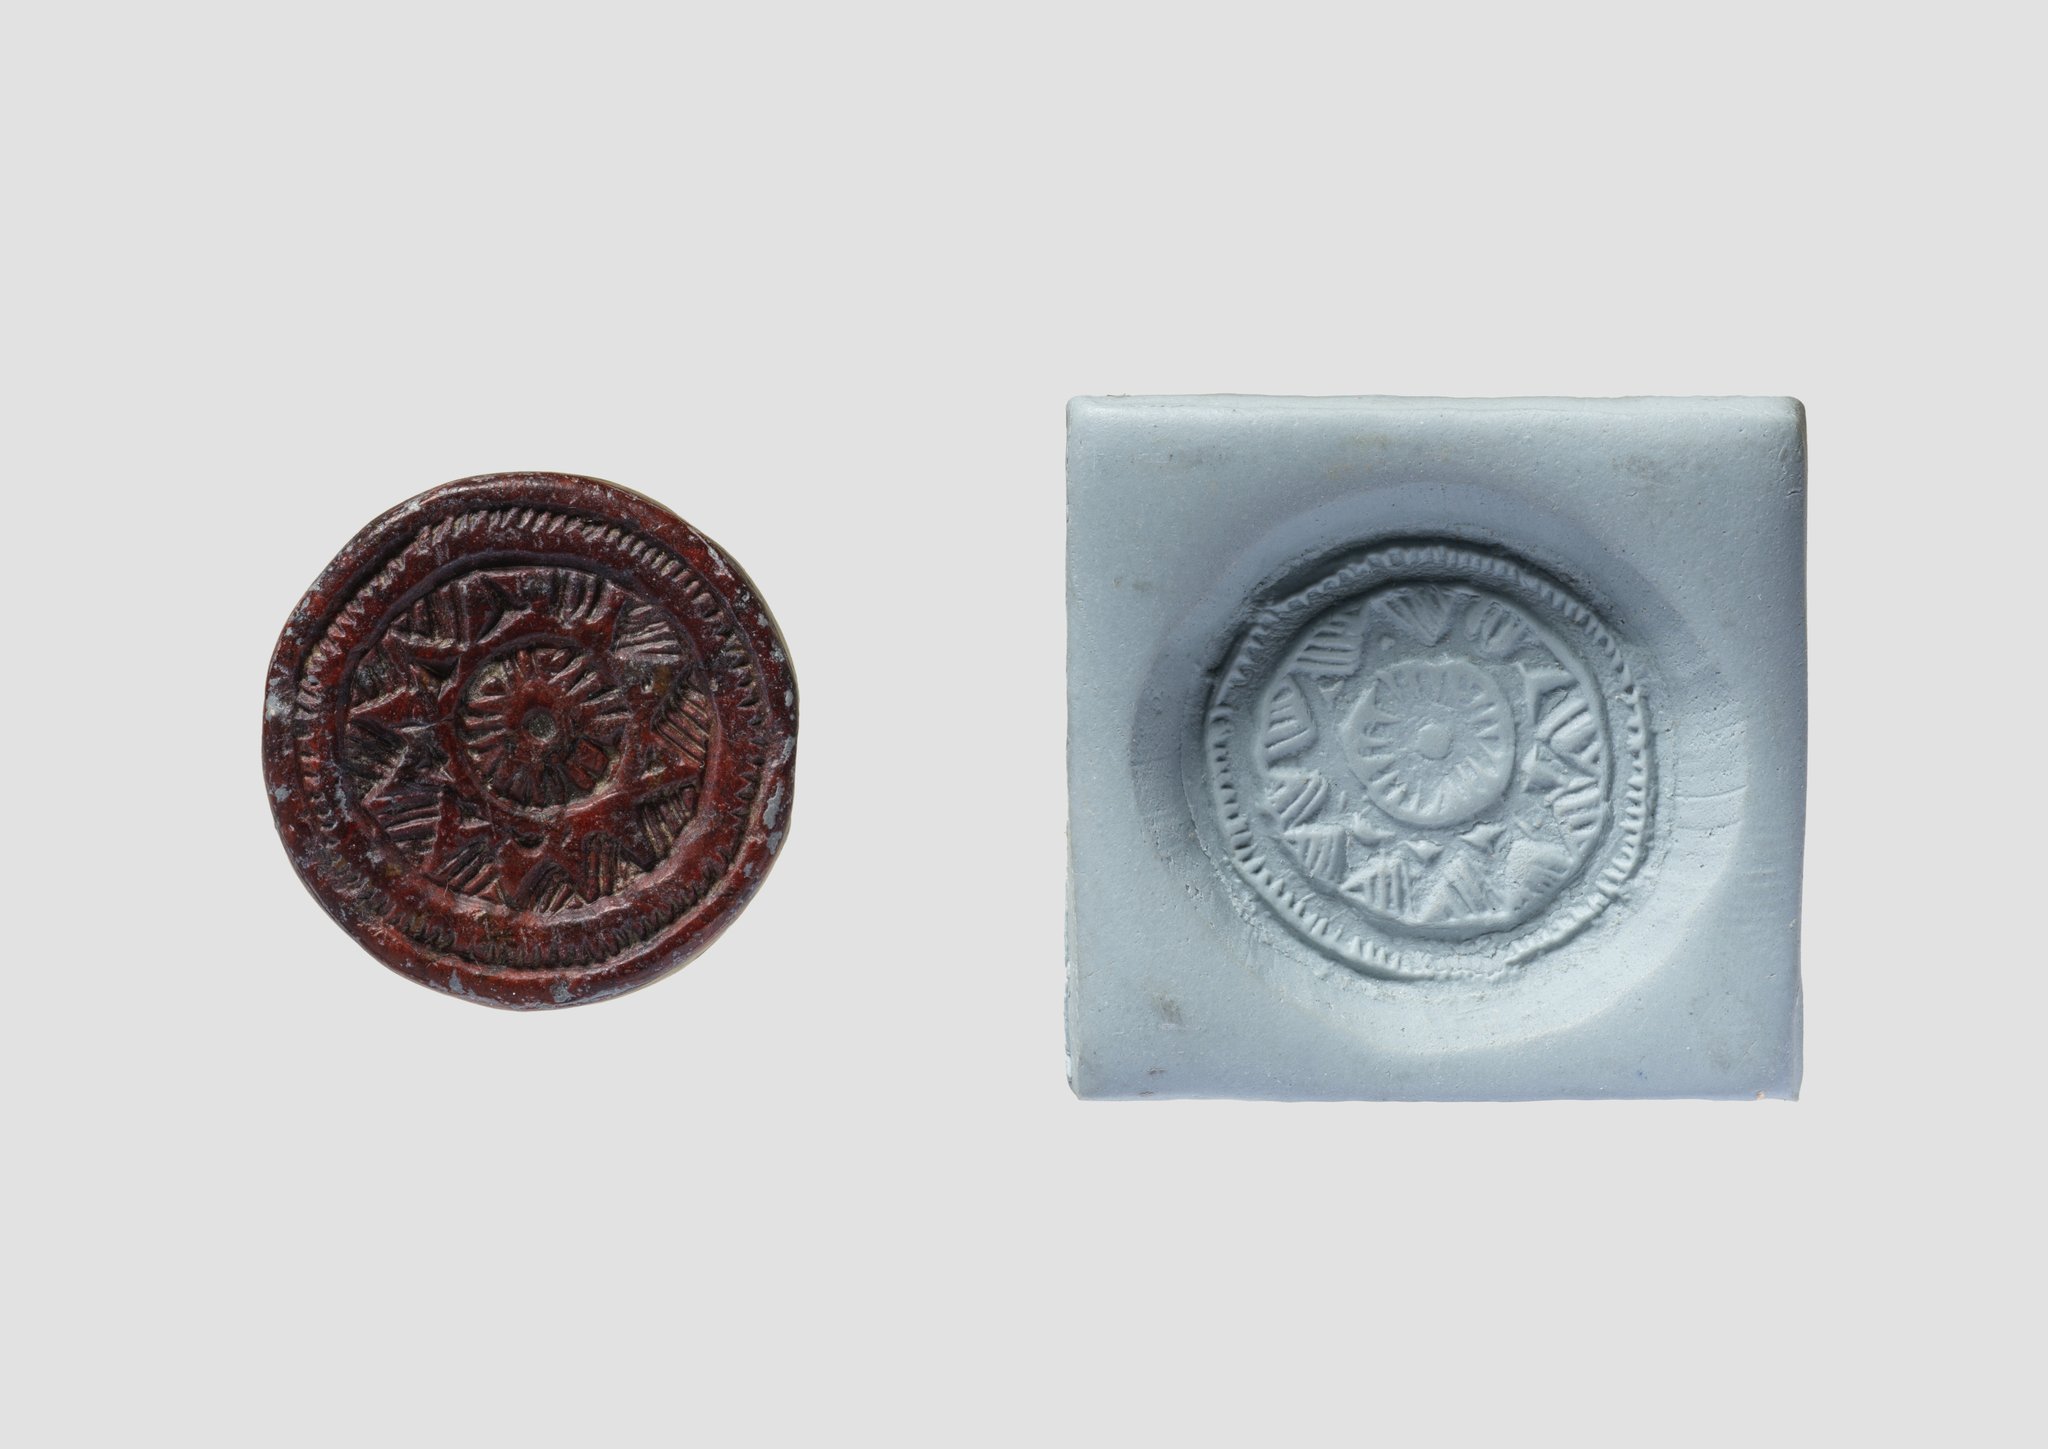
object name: stamp seal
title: Discoid seal engraved on both faces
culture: hittite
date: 1400-1200 BCE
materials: stone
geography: syria or anatolia